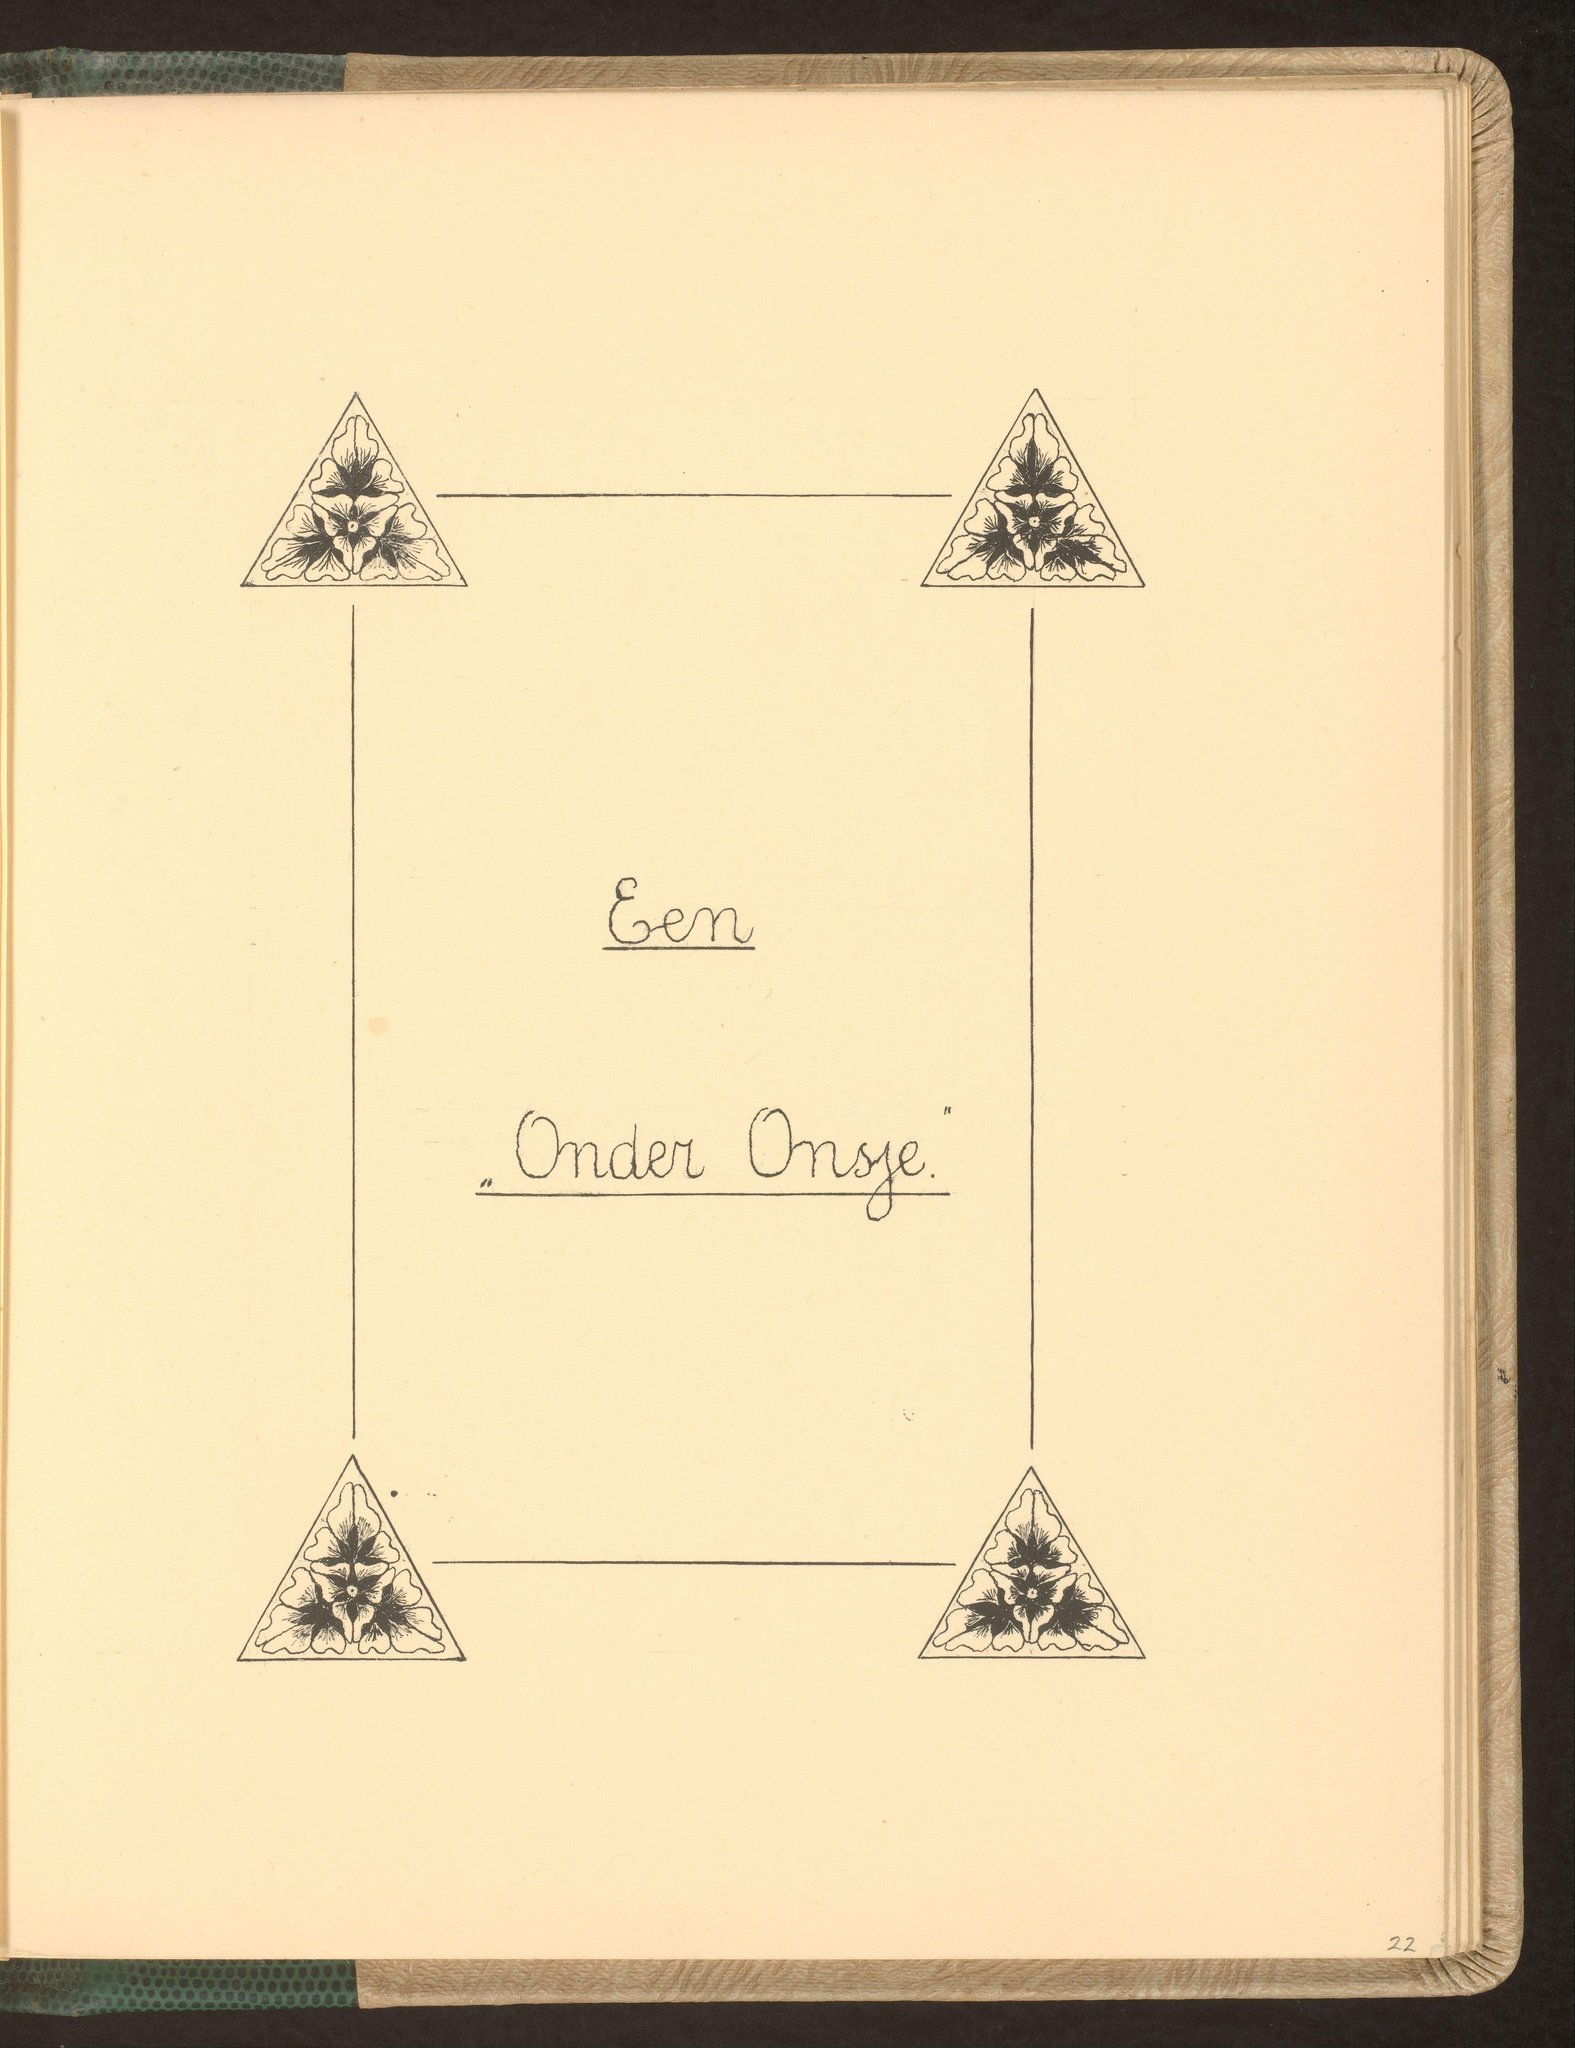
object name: manuscript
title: Een "Onder Onsje"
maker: Anonymous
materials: ink, paper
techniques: handwriting, pen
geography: lochem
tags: amsterdam, the hague, willem drees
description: Handgeschreven titel voor de foto op het volgende blad. Onderdeel van het fotoalbum over de opening van het bejaardenhuis De Berkelhof in Lochem door premier Willem Drees op 8 augustus 1953.